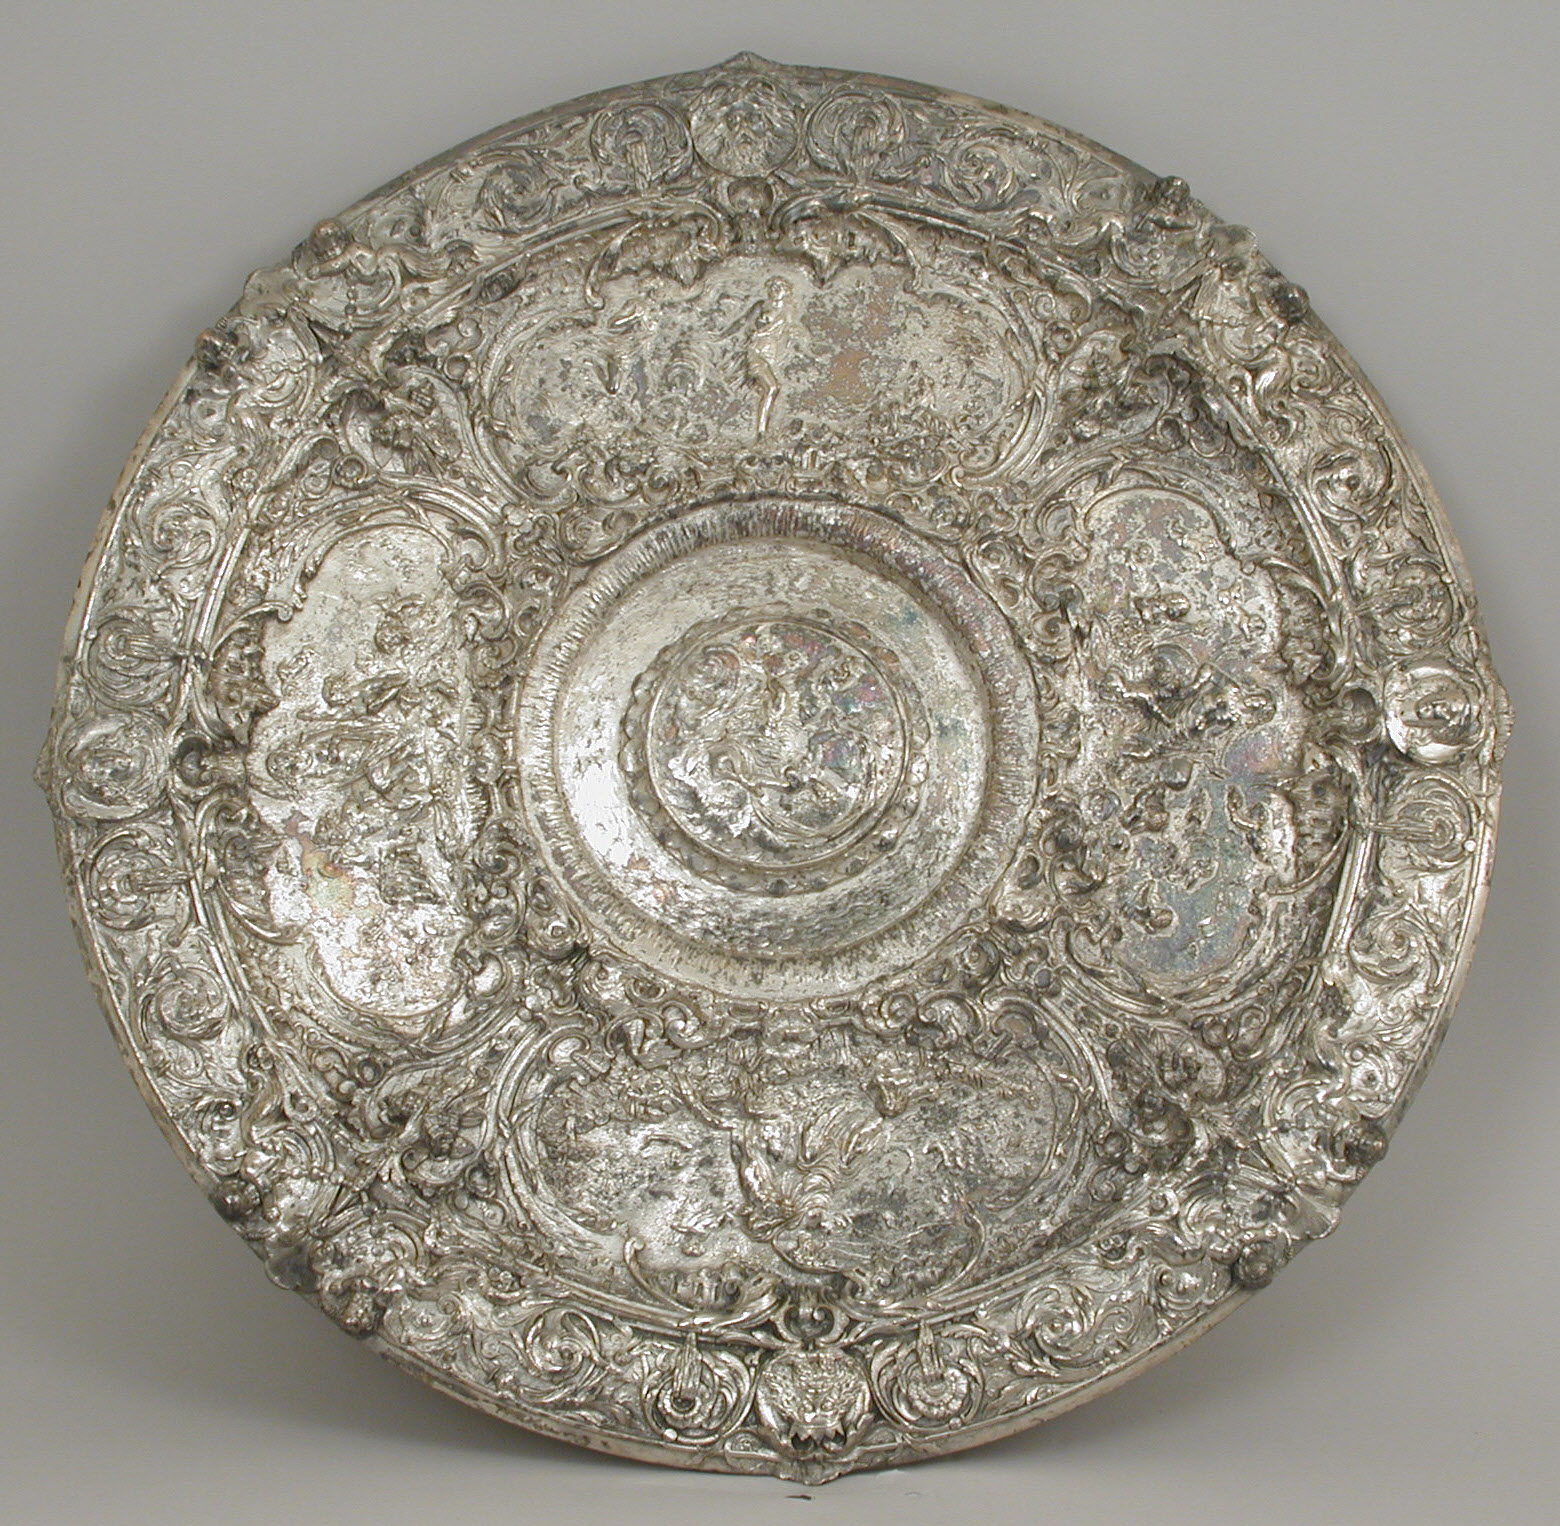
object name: salver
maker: alexandre gueyton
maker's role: maker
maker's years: 1800-1900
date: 1801-1900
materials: metal, silver